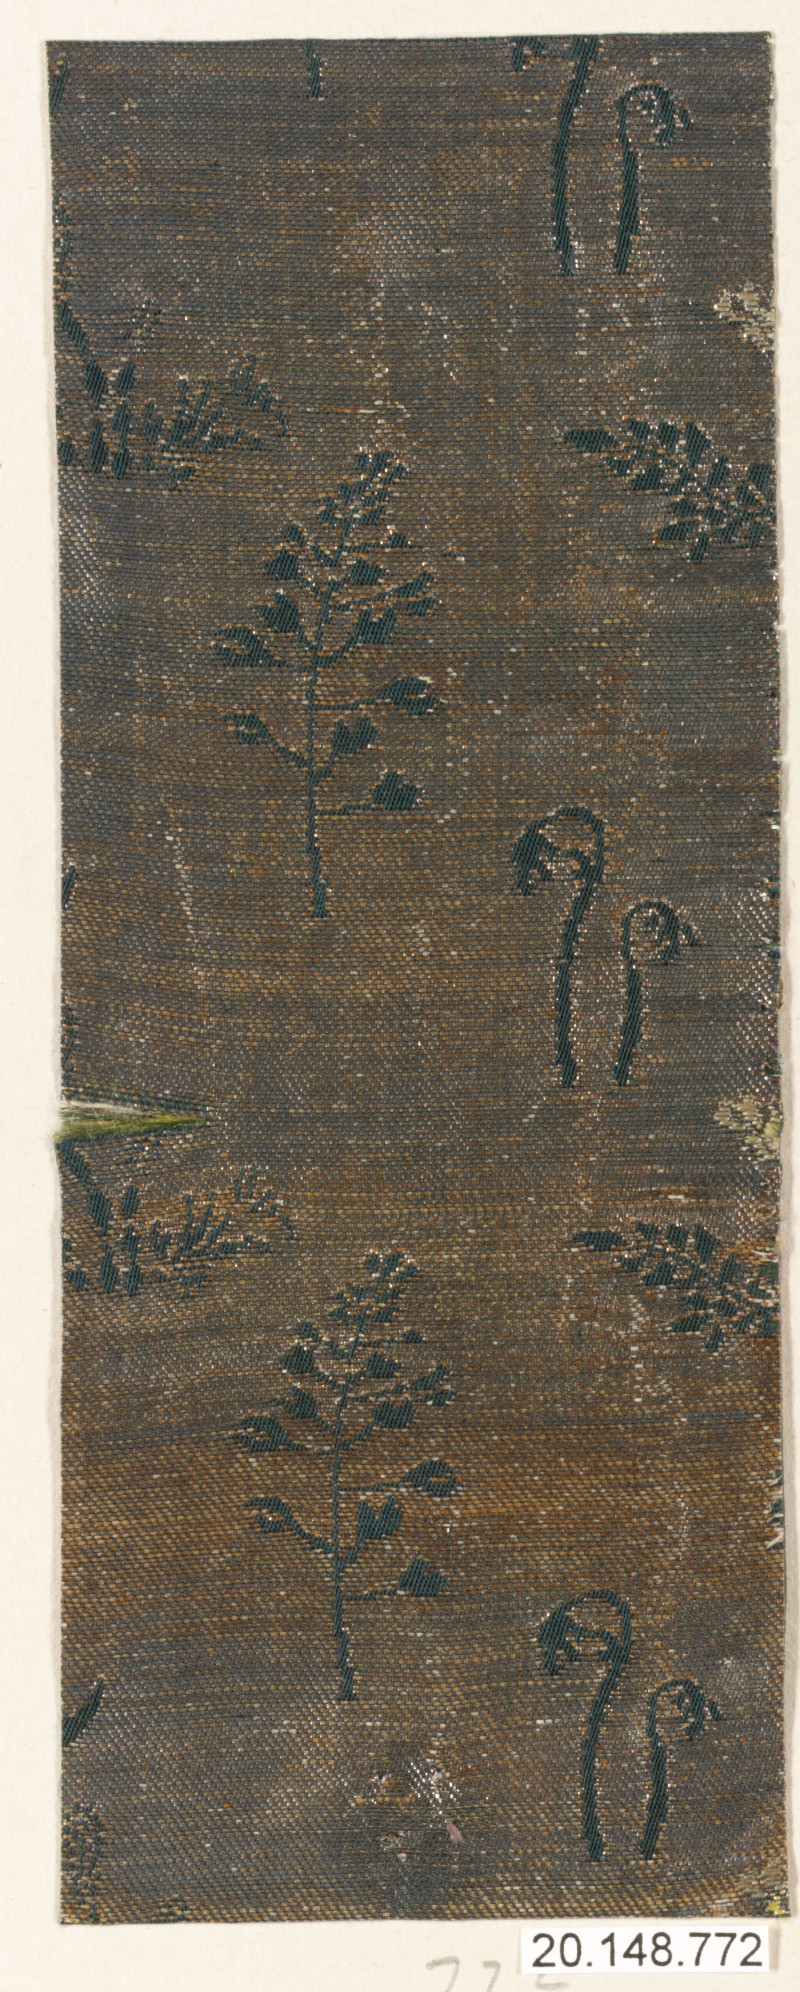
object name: piece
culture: japanese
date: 1601-1700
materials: silk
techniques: compound weave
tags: plants